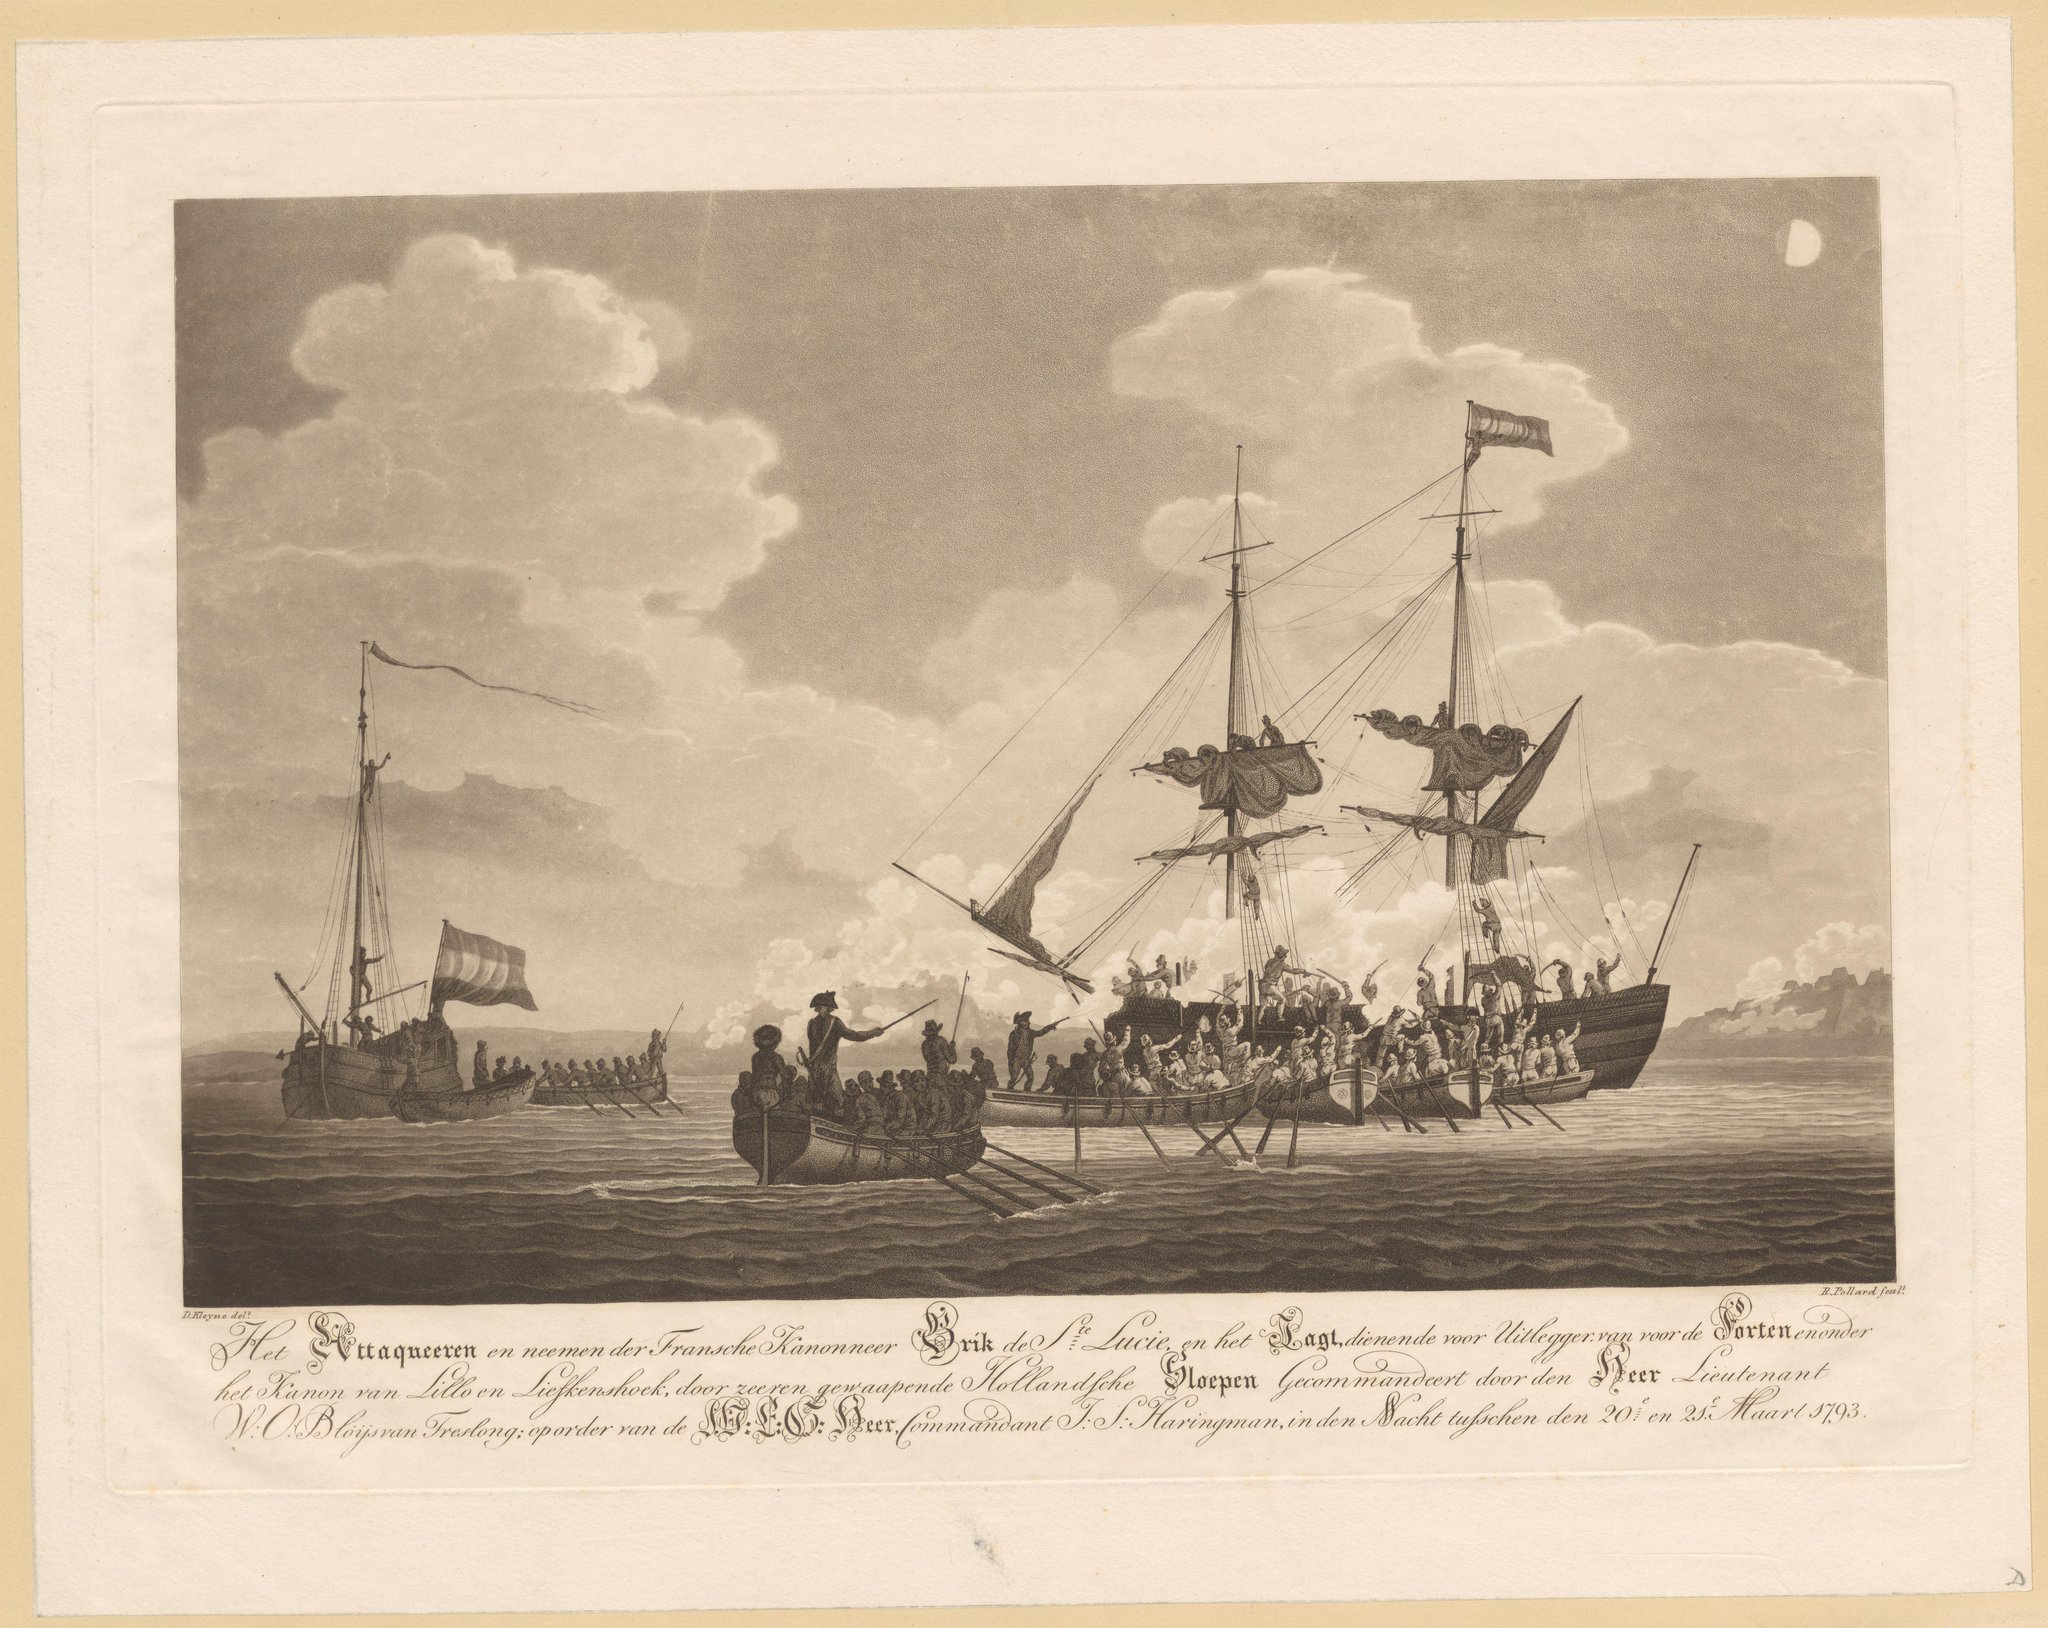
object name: print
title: Verovering van de Franse kanonneerboot Ste. Lucie, 1793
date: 1793-1795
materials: paper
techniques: aquatint, etching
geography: middelburg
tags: battle (+ naval force)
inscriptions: collector's mark: Lugt 2228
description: De verovering van de Franse kanonneerboot Ste. Lucie en het gaffeljacht met zeven sloepen met in totaal 140 man, op de Schelde, in nacht van 20 op 21 maart 1793. Expeditie op orders van commandant Jan Schreuder Haringman en uitgevoerd door luitenant Willem Otto Bloys van Treslong.